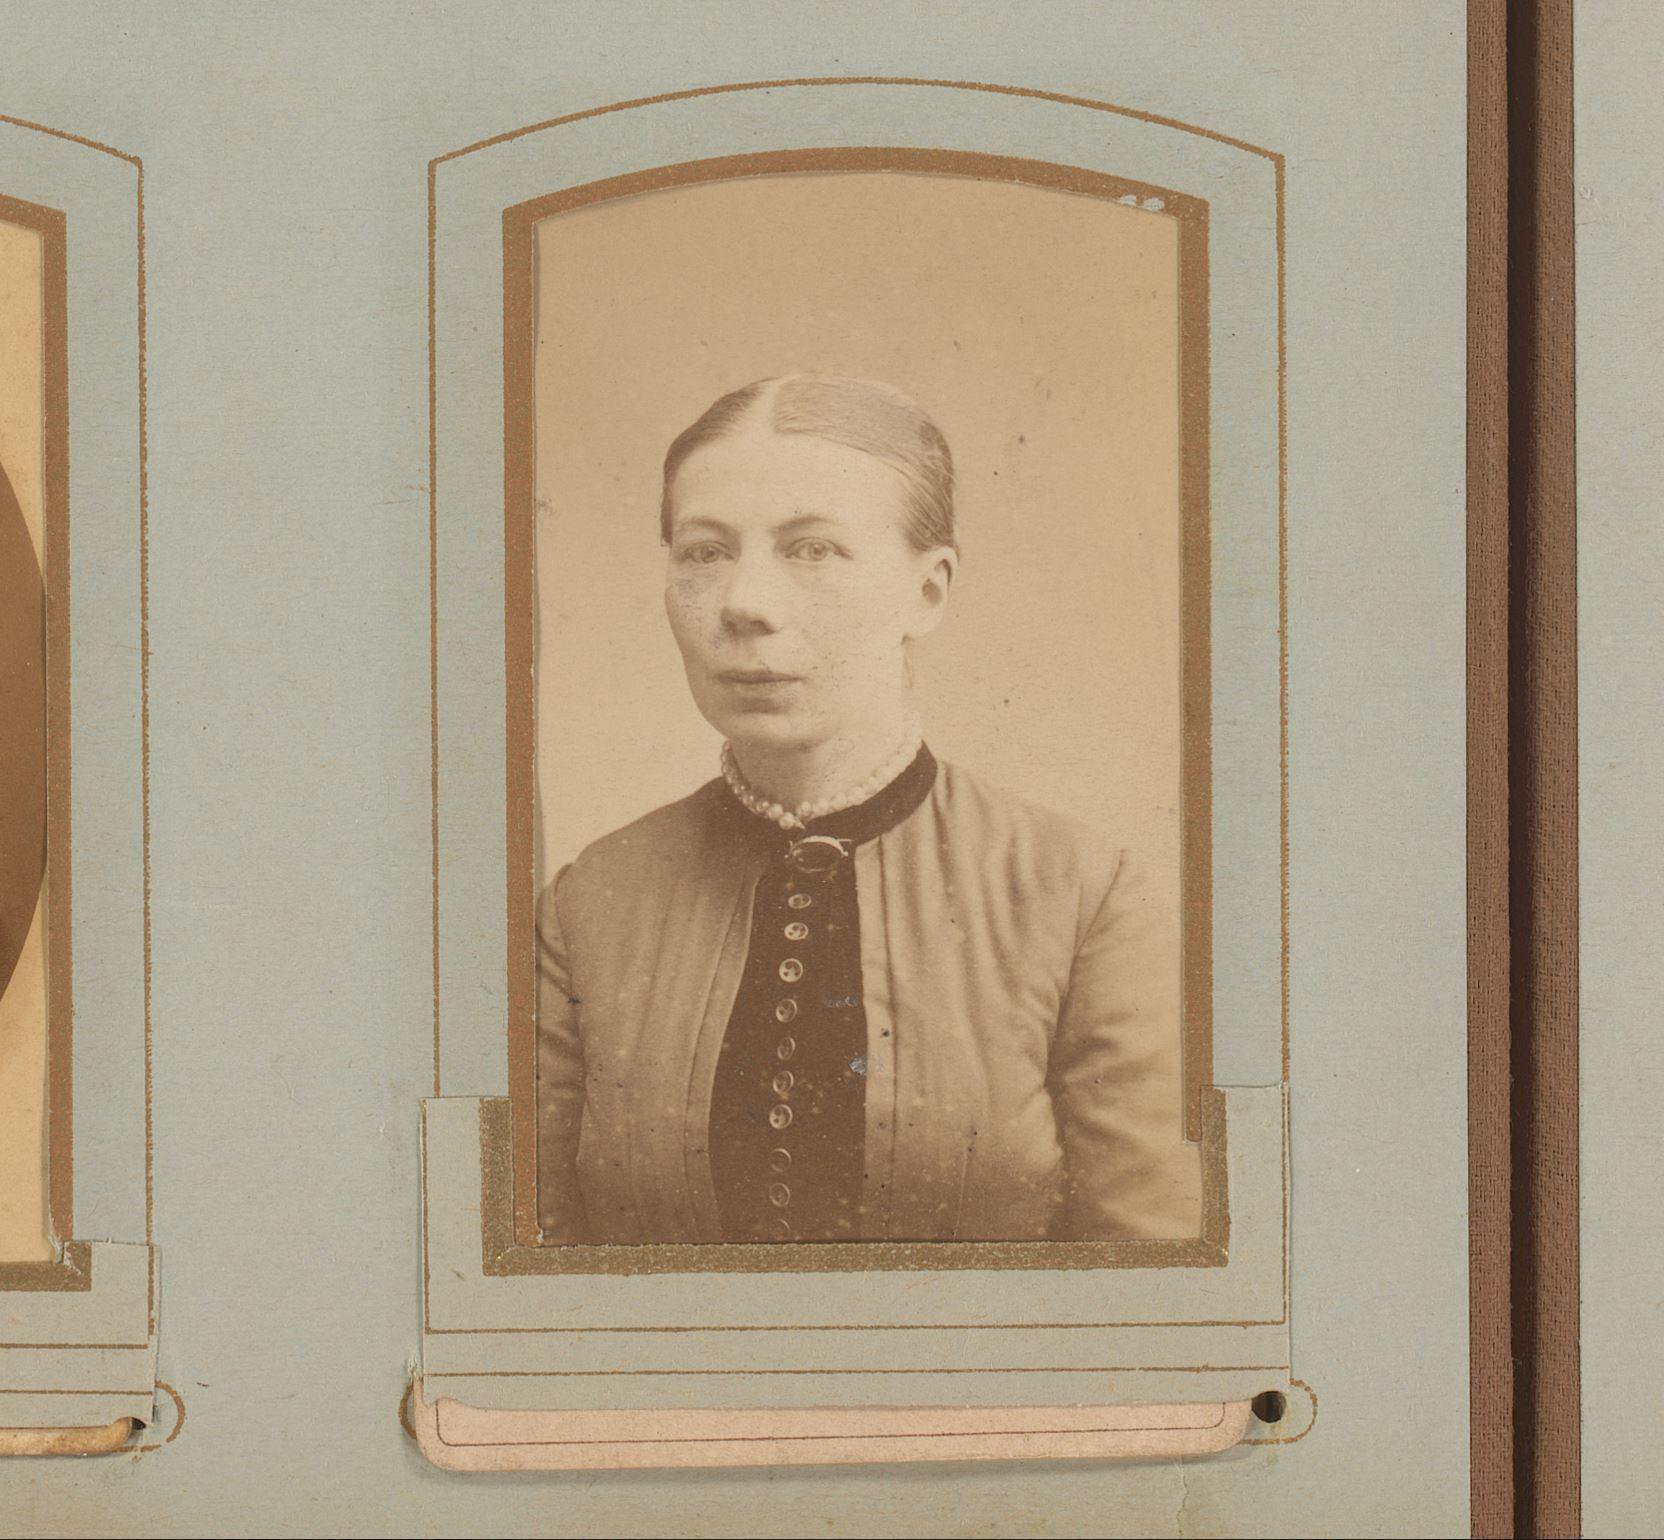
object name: photograph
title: Portret van een vrouw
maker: Anonymous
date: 1870-1900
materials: cardboard, photographic support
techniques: albumen print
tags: historical persons - bb - woman